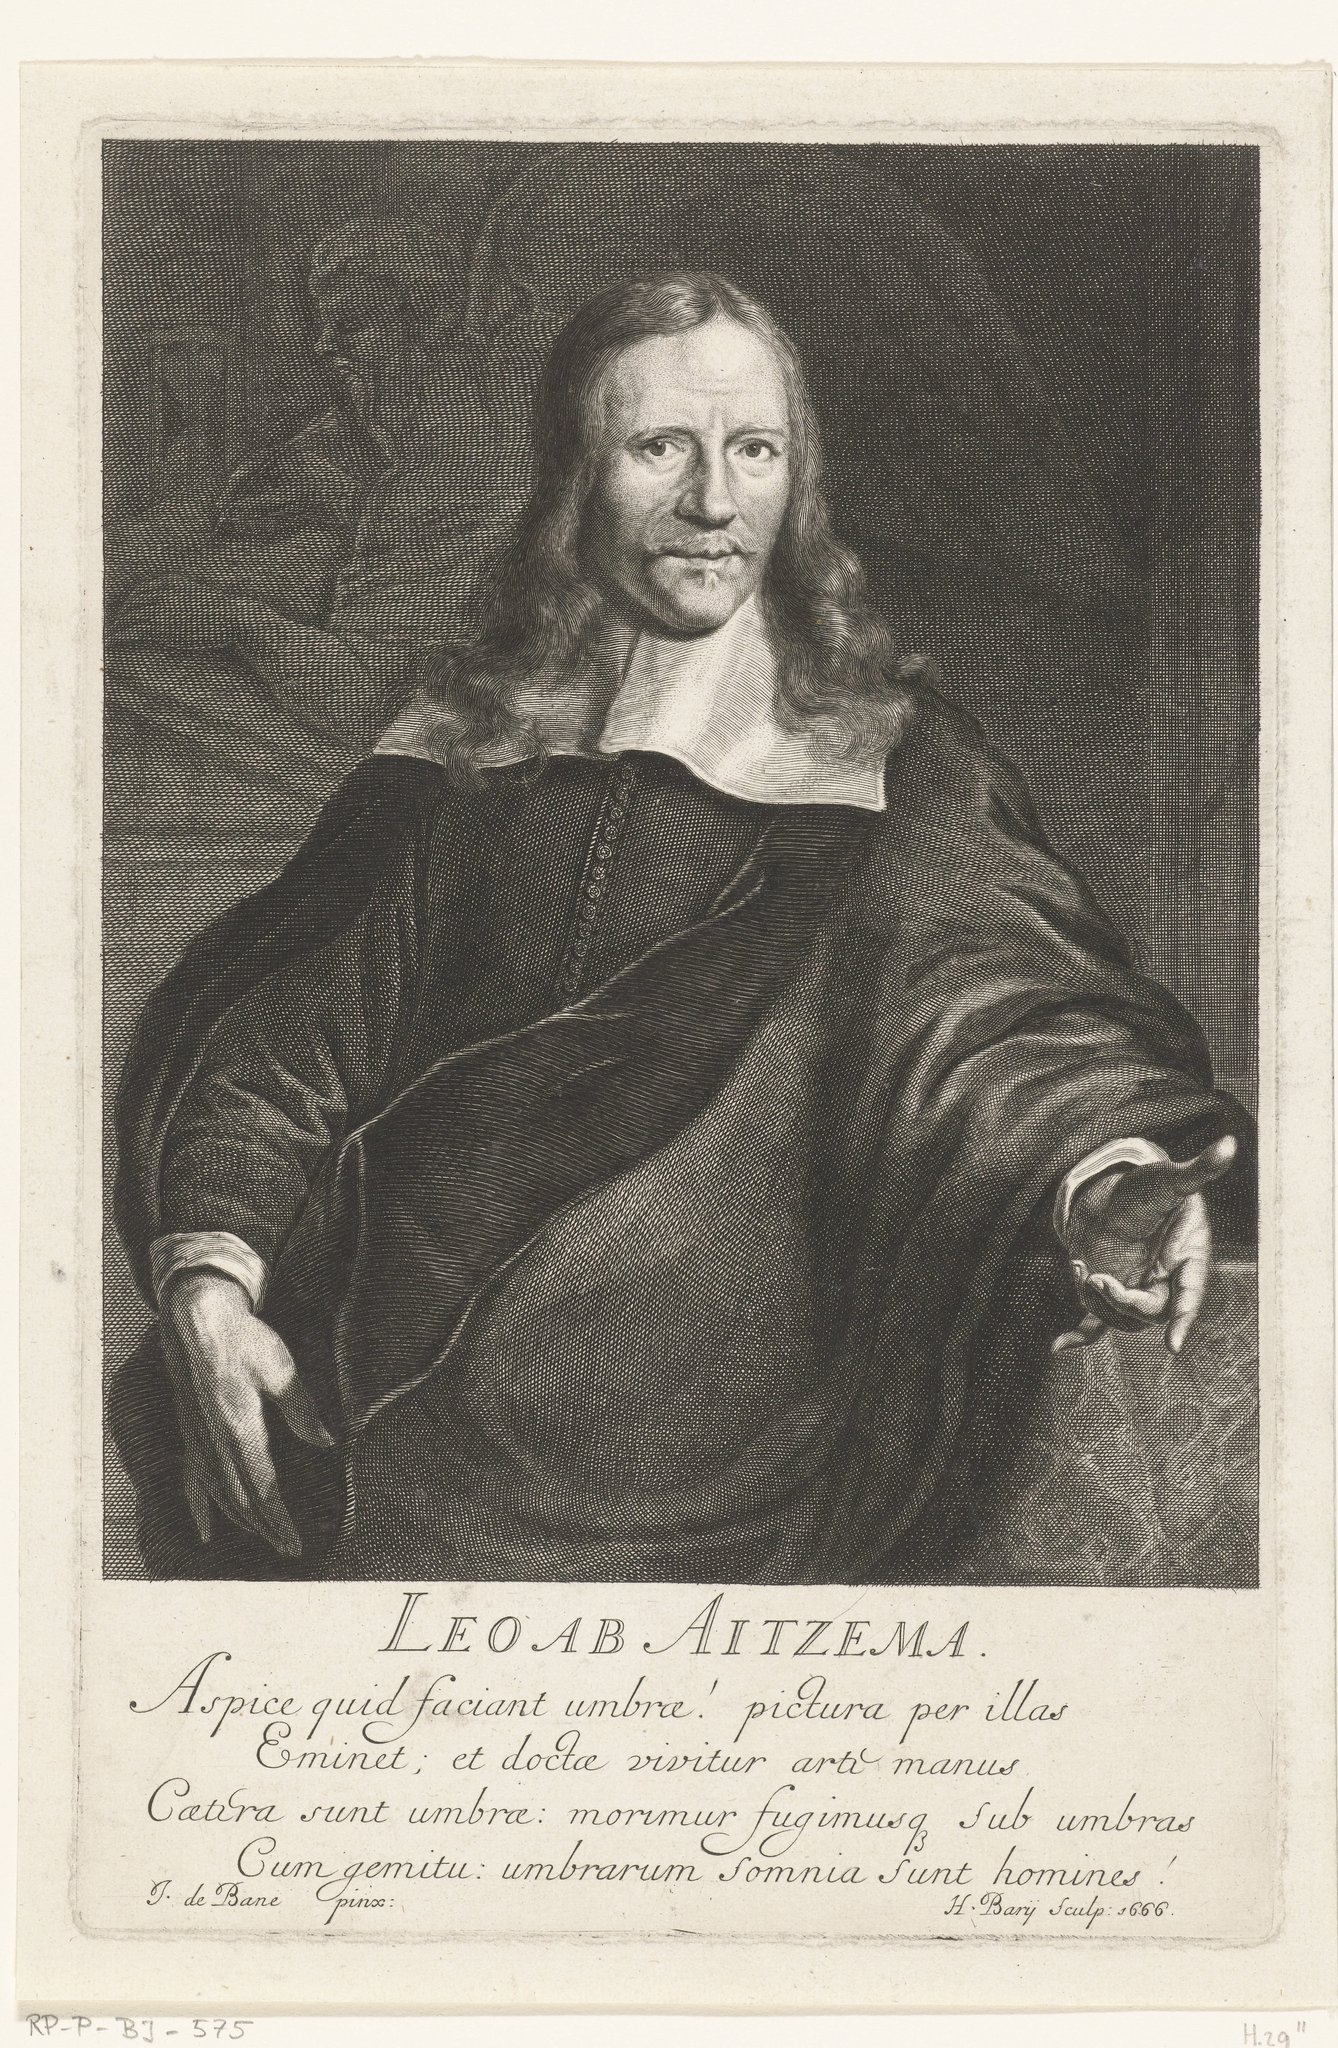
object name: print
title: Portret van Lieuwe van Aitzema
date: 1666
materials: paper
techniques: engraving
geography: netherlands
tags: the hague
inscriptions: collector's mark: Lugt 240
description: Portret van Lieuwe van Aitzema. Onder het portret een Latijns vers van vier regels.